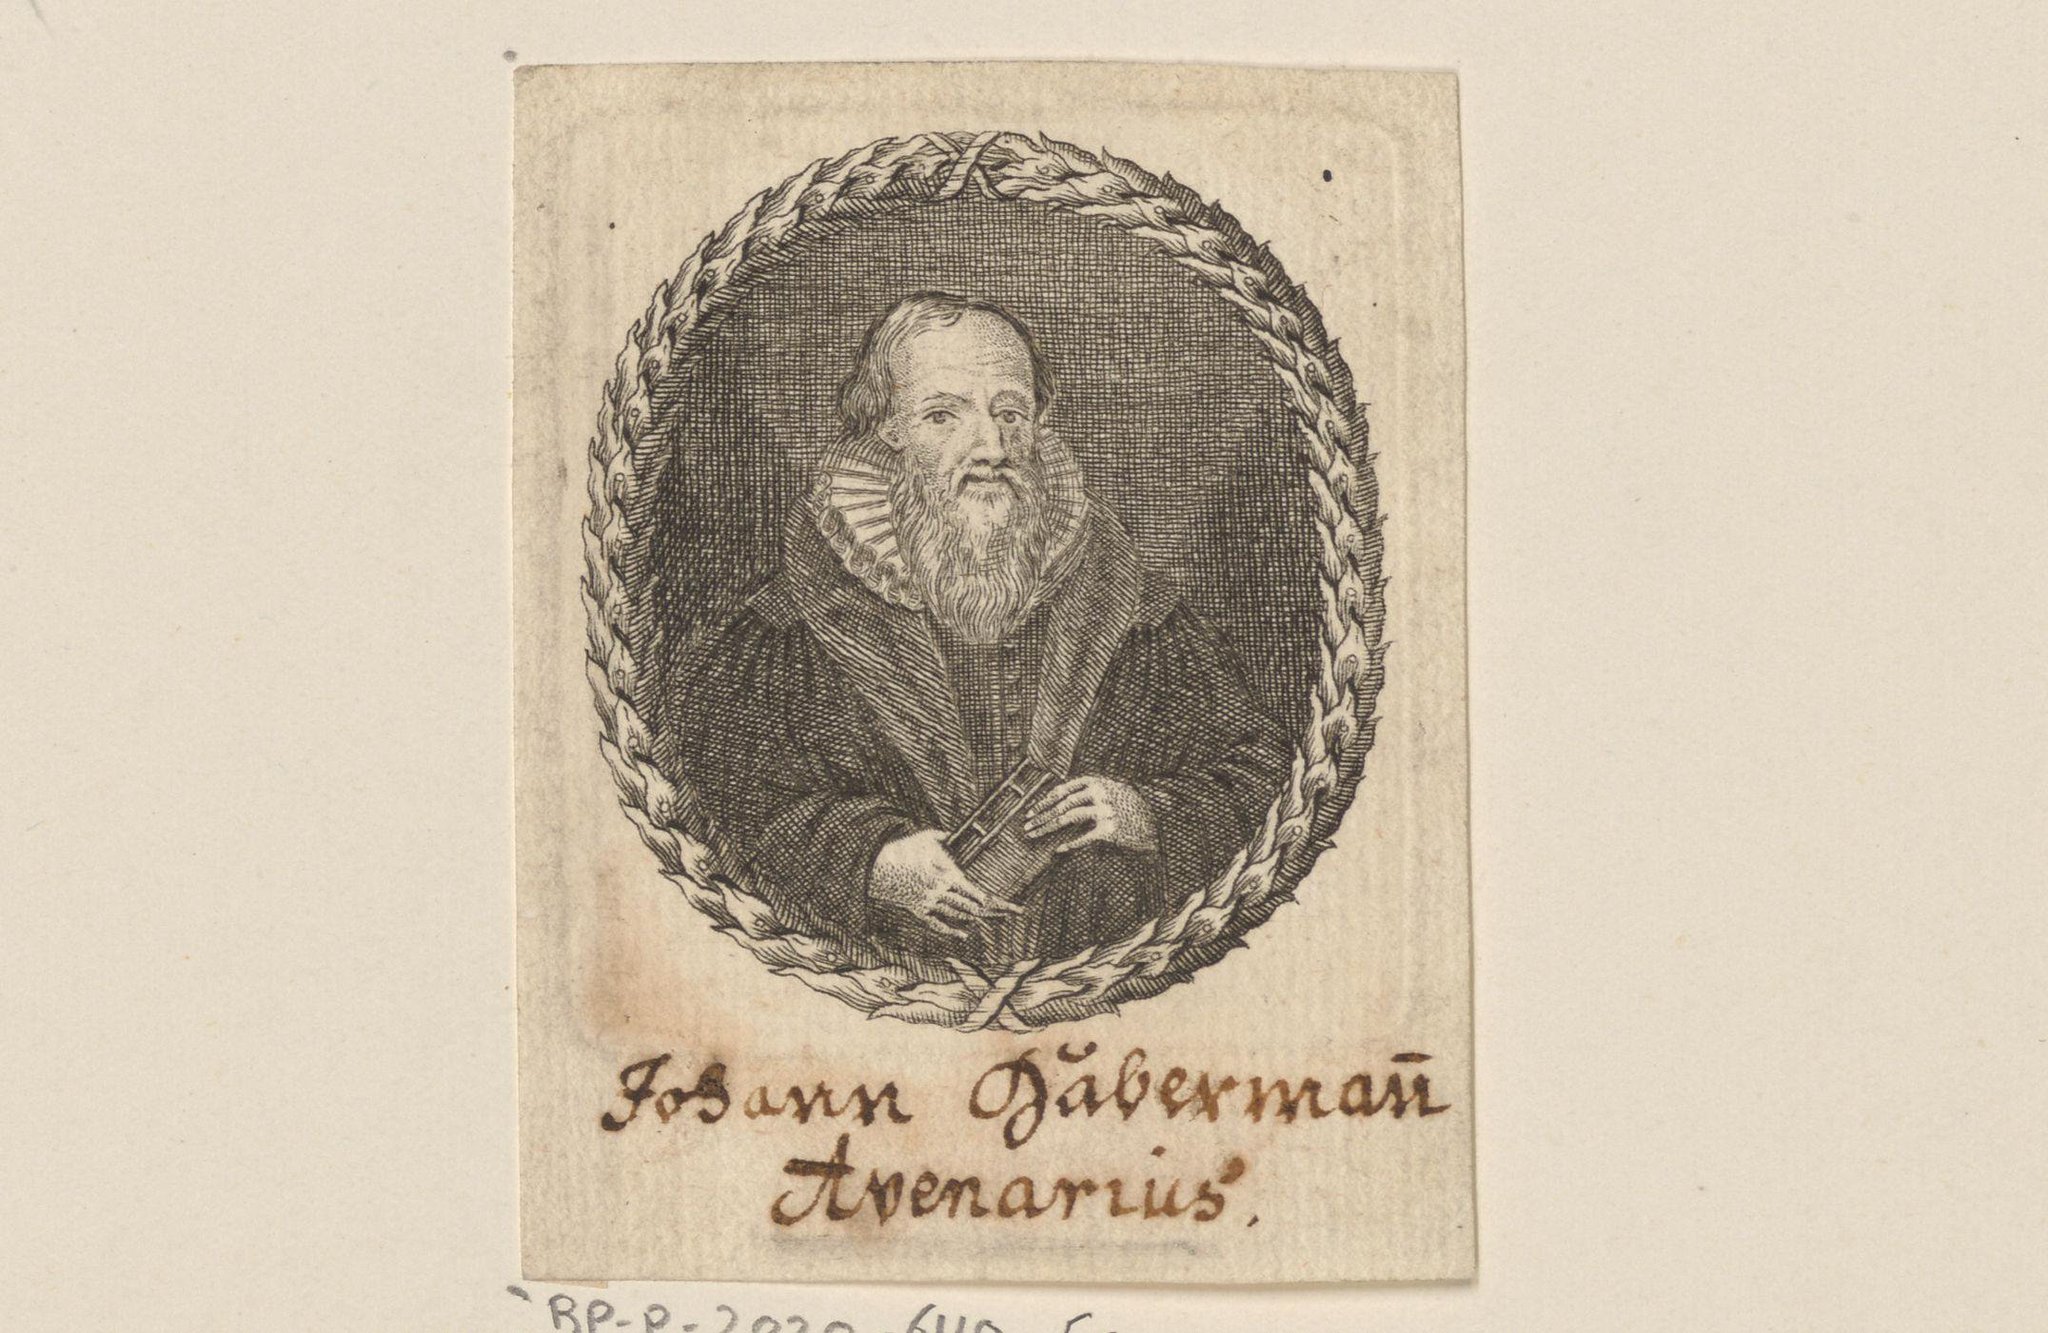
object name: print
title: Portret van Johann Habermann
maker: Anonymous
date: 1650-1699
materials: paper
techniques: engraving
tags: theologian, historical persons, book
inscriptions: inscription: ‘Johann Haberman[n]/ Avenarius.’